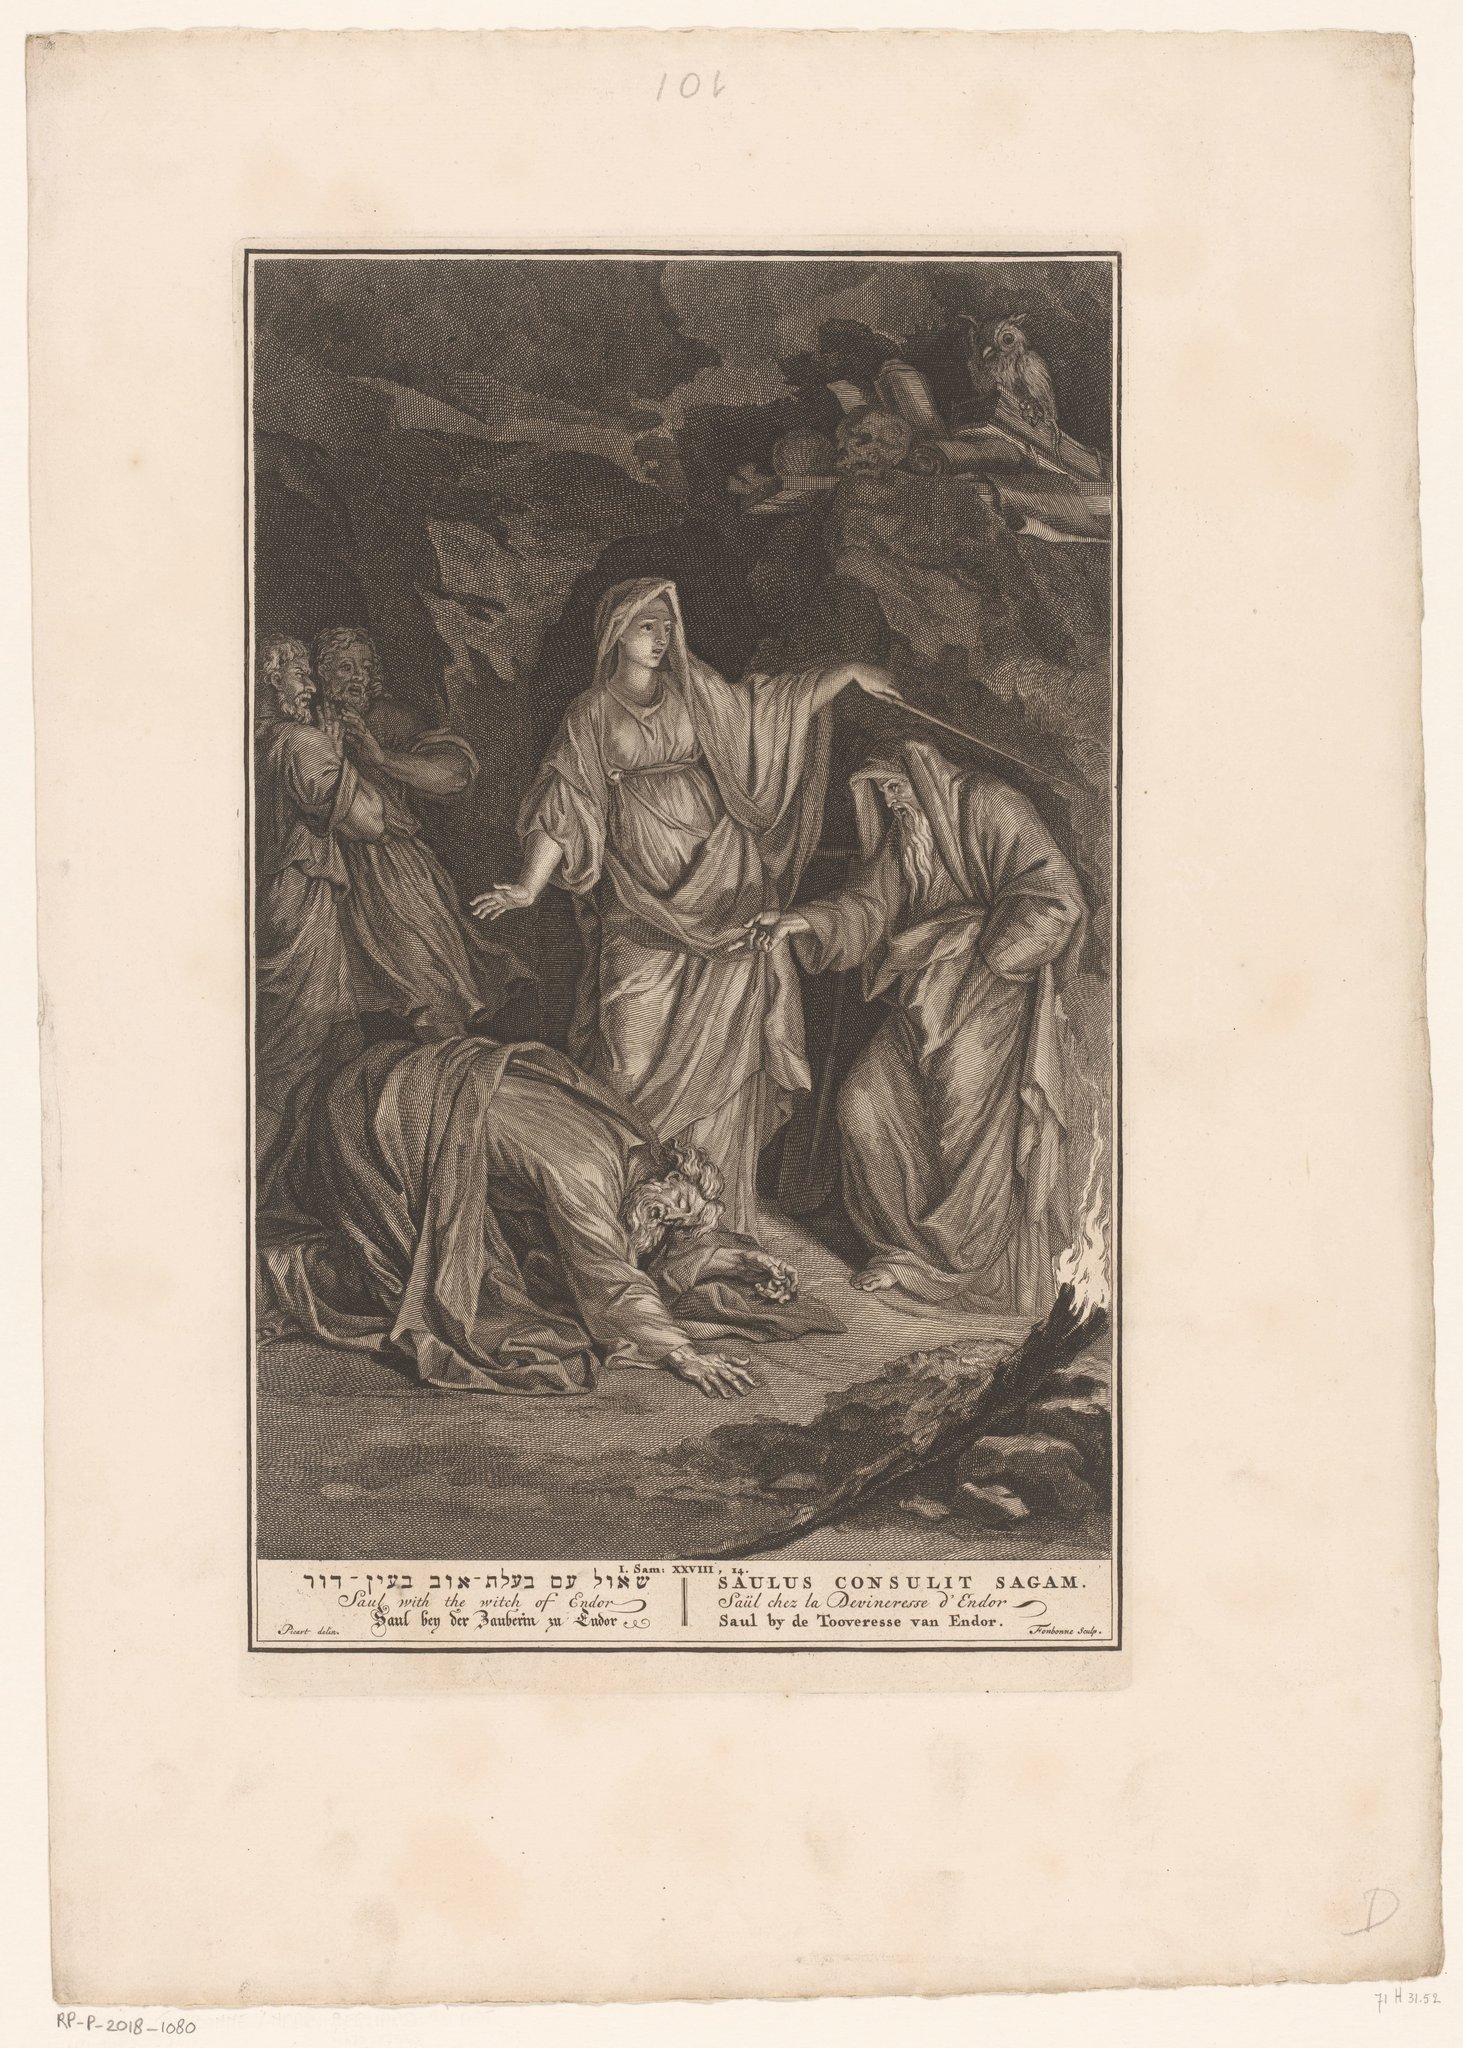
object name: print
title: Saul bij de heks van Endor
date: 1690-1757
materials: paper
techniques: engraving, etching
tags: the ghost of samuel appears to the witch of endor; saul falls prostrate to the ground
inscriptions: collector's mark: Lugt 2228